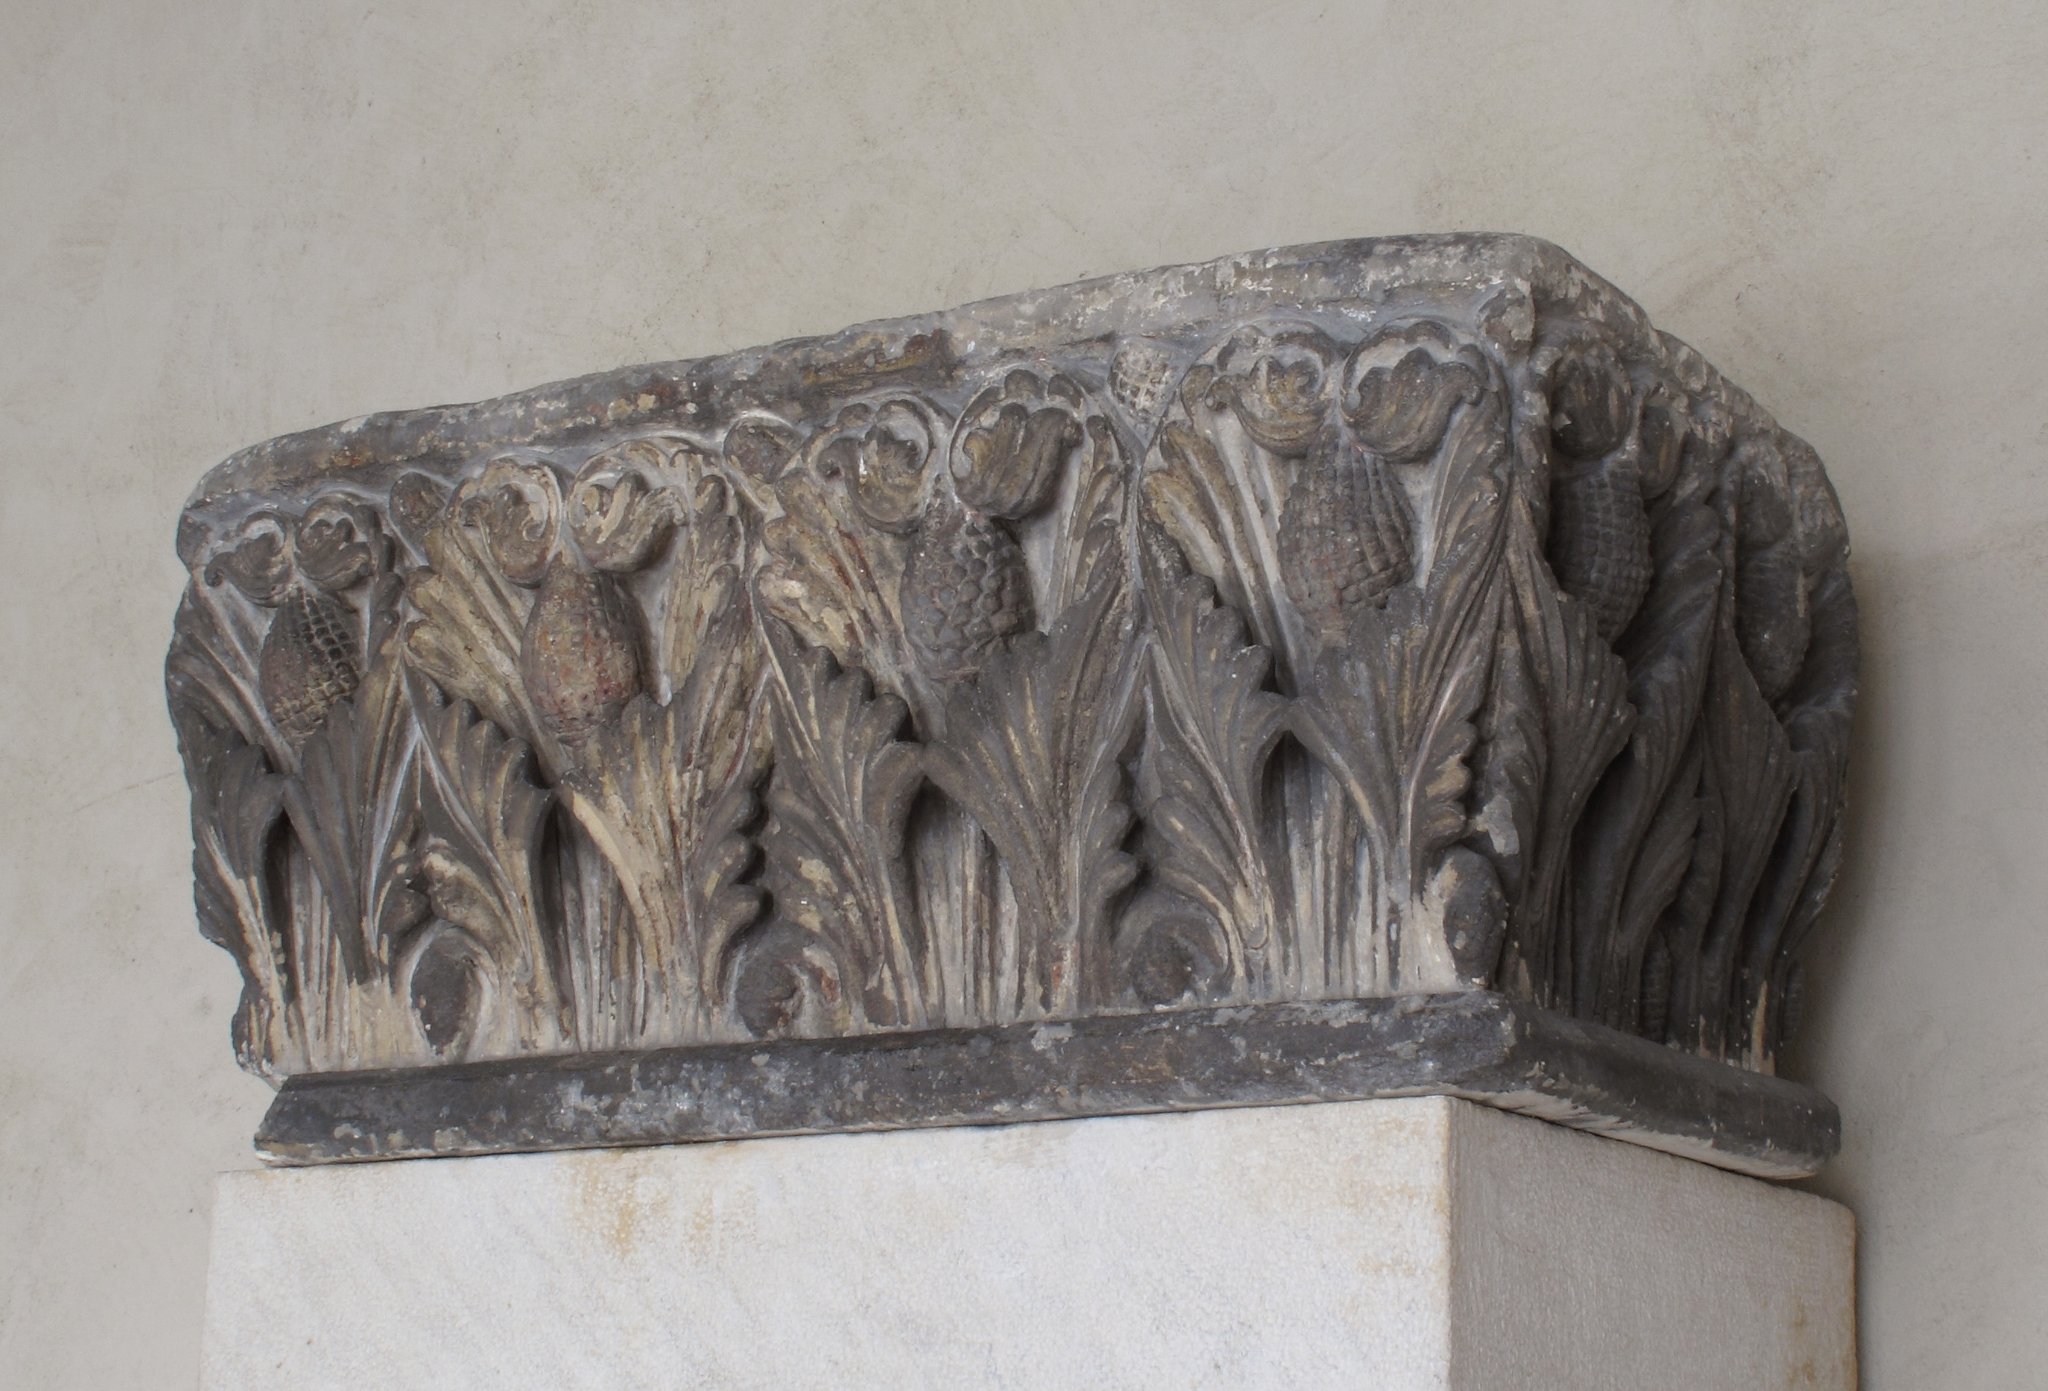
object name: capital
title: Impost Capital with Acanthus Leaf Decoration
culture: french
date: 1134-1166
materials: limestone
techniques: polychromy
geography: france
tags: leaves